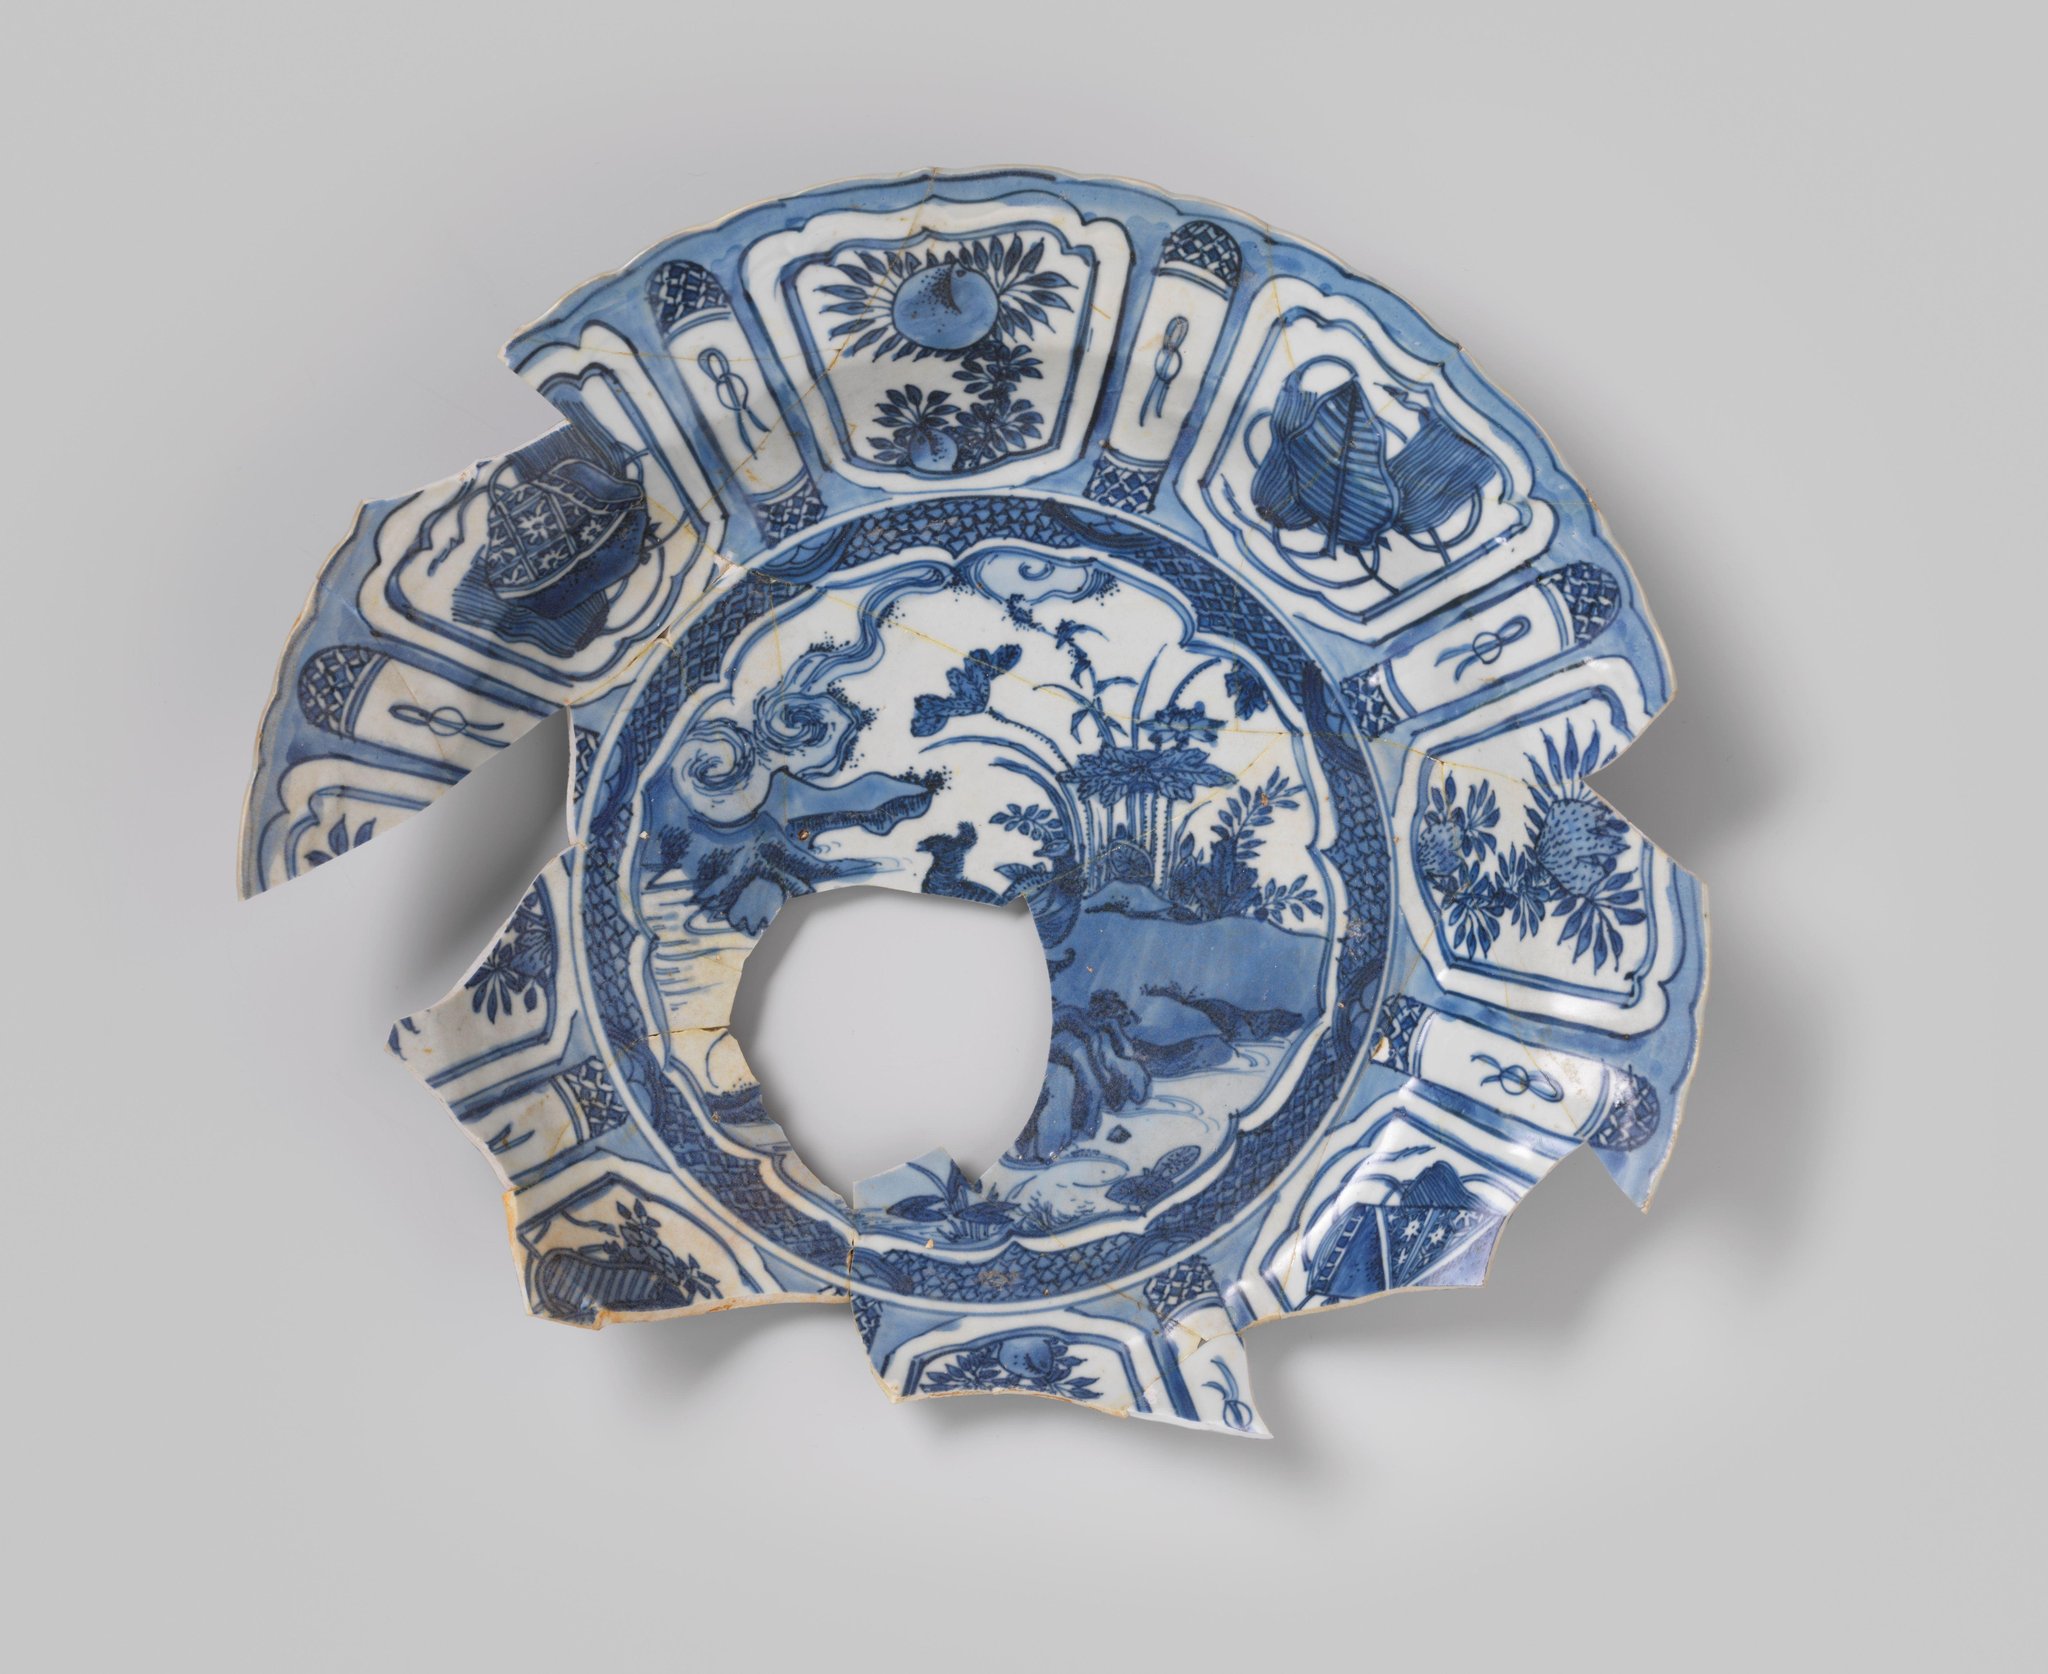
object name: sherd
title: Dish of Chinese porcelain from the wreck of the Dutch East Indiaman Witte Leeuw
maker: Anonymous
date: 1613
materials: bone china, glaze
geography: jingdezhen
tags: verenigde oostindische compagnie, sint-helena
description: Fragment bord uit V.O.C.-schip de 'Witte Leeuw', 80% aanwezig. De scherf is glasachtig wit en kent weinig ingebakken vuil. Het glazuur is blauw getint en bladdert af over gedeelten van de liprand. Ook zitten er pinholes en kleine bakscheurtjes in het glazuur op de hoeken van de liprand. De bodem is geglazuurd. De voetring is v-vormig, gefacetteerd en staat naar binnen. Er zijn meer dan 20 korrels ovenzand aangetroffen. Achttien aan elkaar gelijmde scherven en een losse scherf.